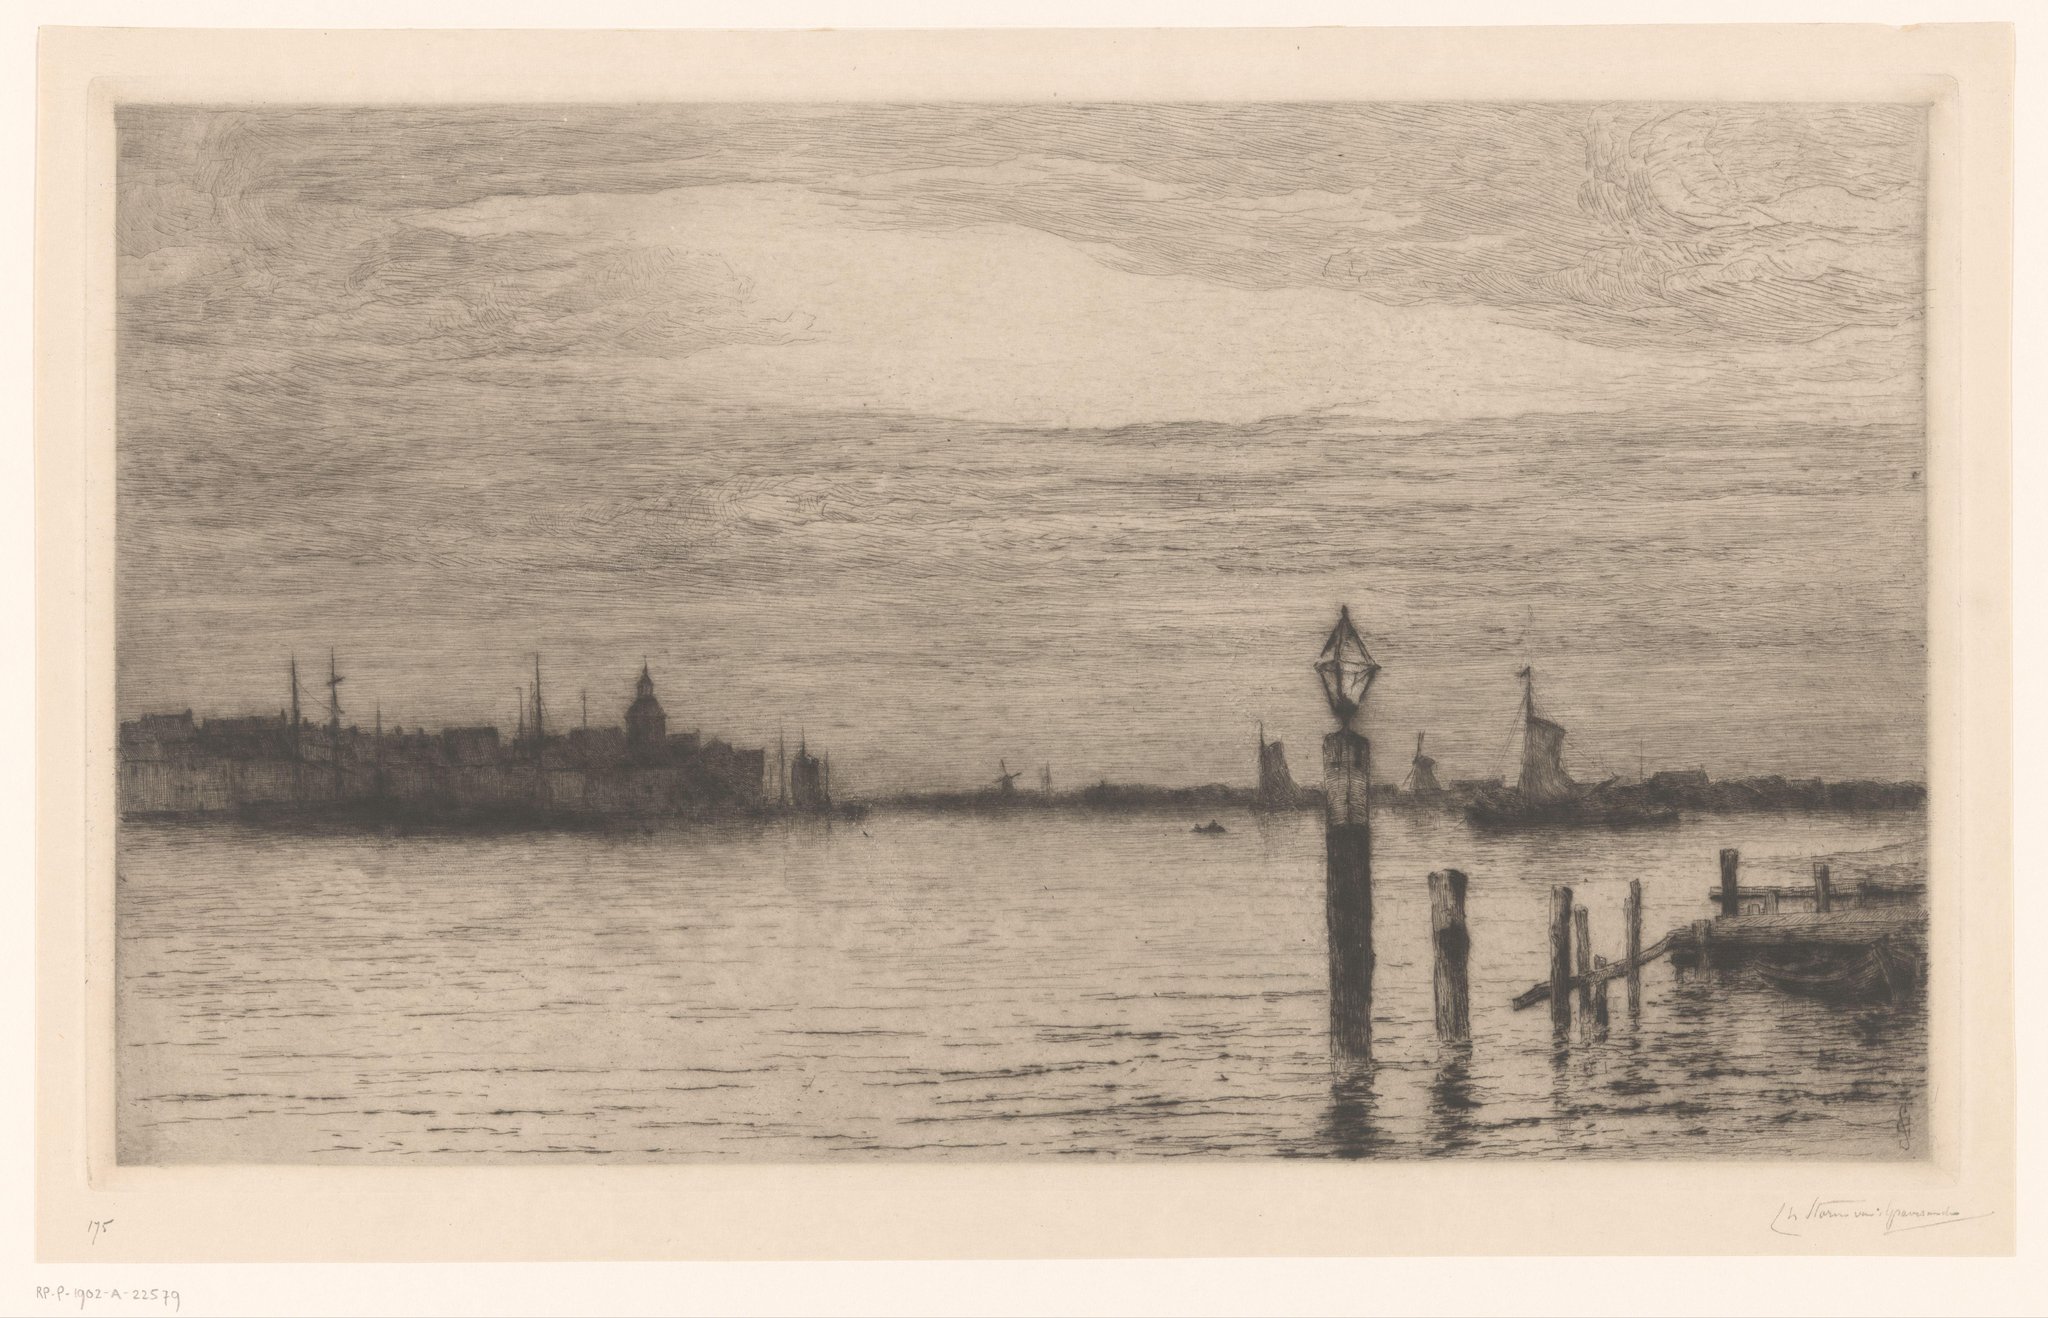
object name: print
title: Gezicht op Dordrecht bij avond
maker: carel nicolaas storm van s-gravesande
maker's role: draughtsman, print maker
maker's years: 1841-1924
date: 1880-1884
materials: paper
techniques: drypoint, intaglio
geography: netherlands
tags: river, evening, prospect of city, town panorama, silhouette of city, dordrecht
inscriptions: collector's mark: Lugt 2228, number: ‘175’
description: Mogelijk vermeld in: Storm van 's-Gravesande, Charles. Catalogue des eaux-fortes et lithographies. New York: s.n., 1903, of in een onbekende latere uitgave van het manuscript. Vermoedelijk vermeld als catalogusnummer 175.